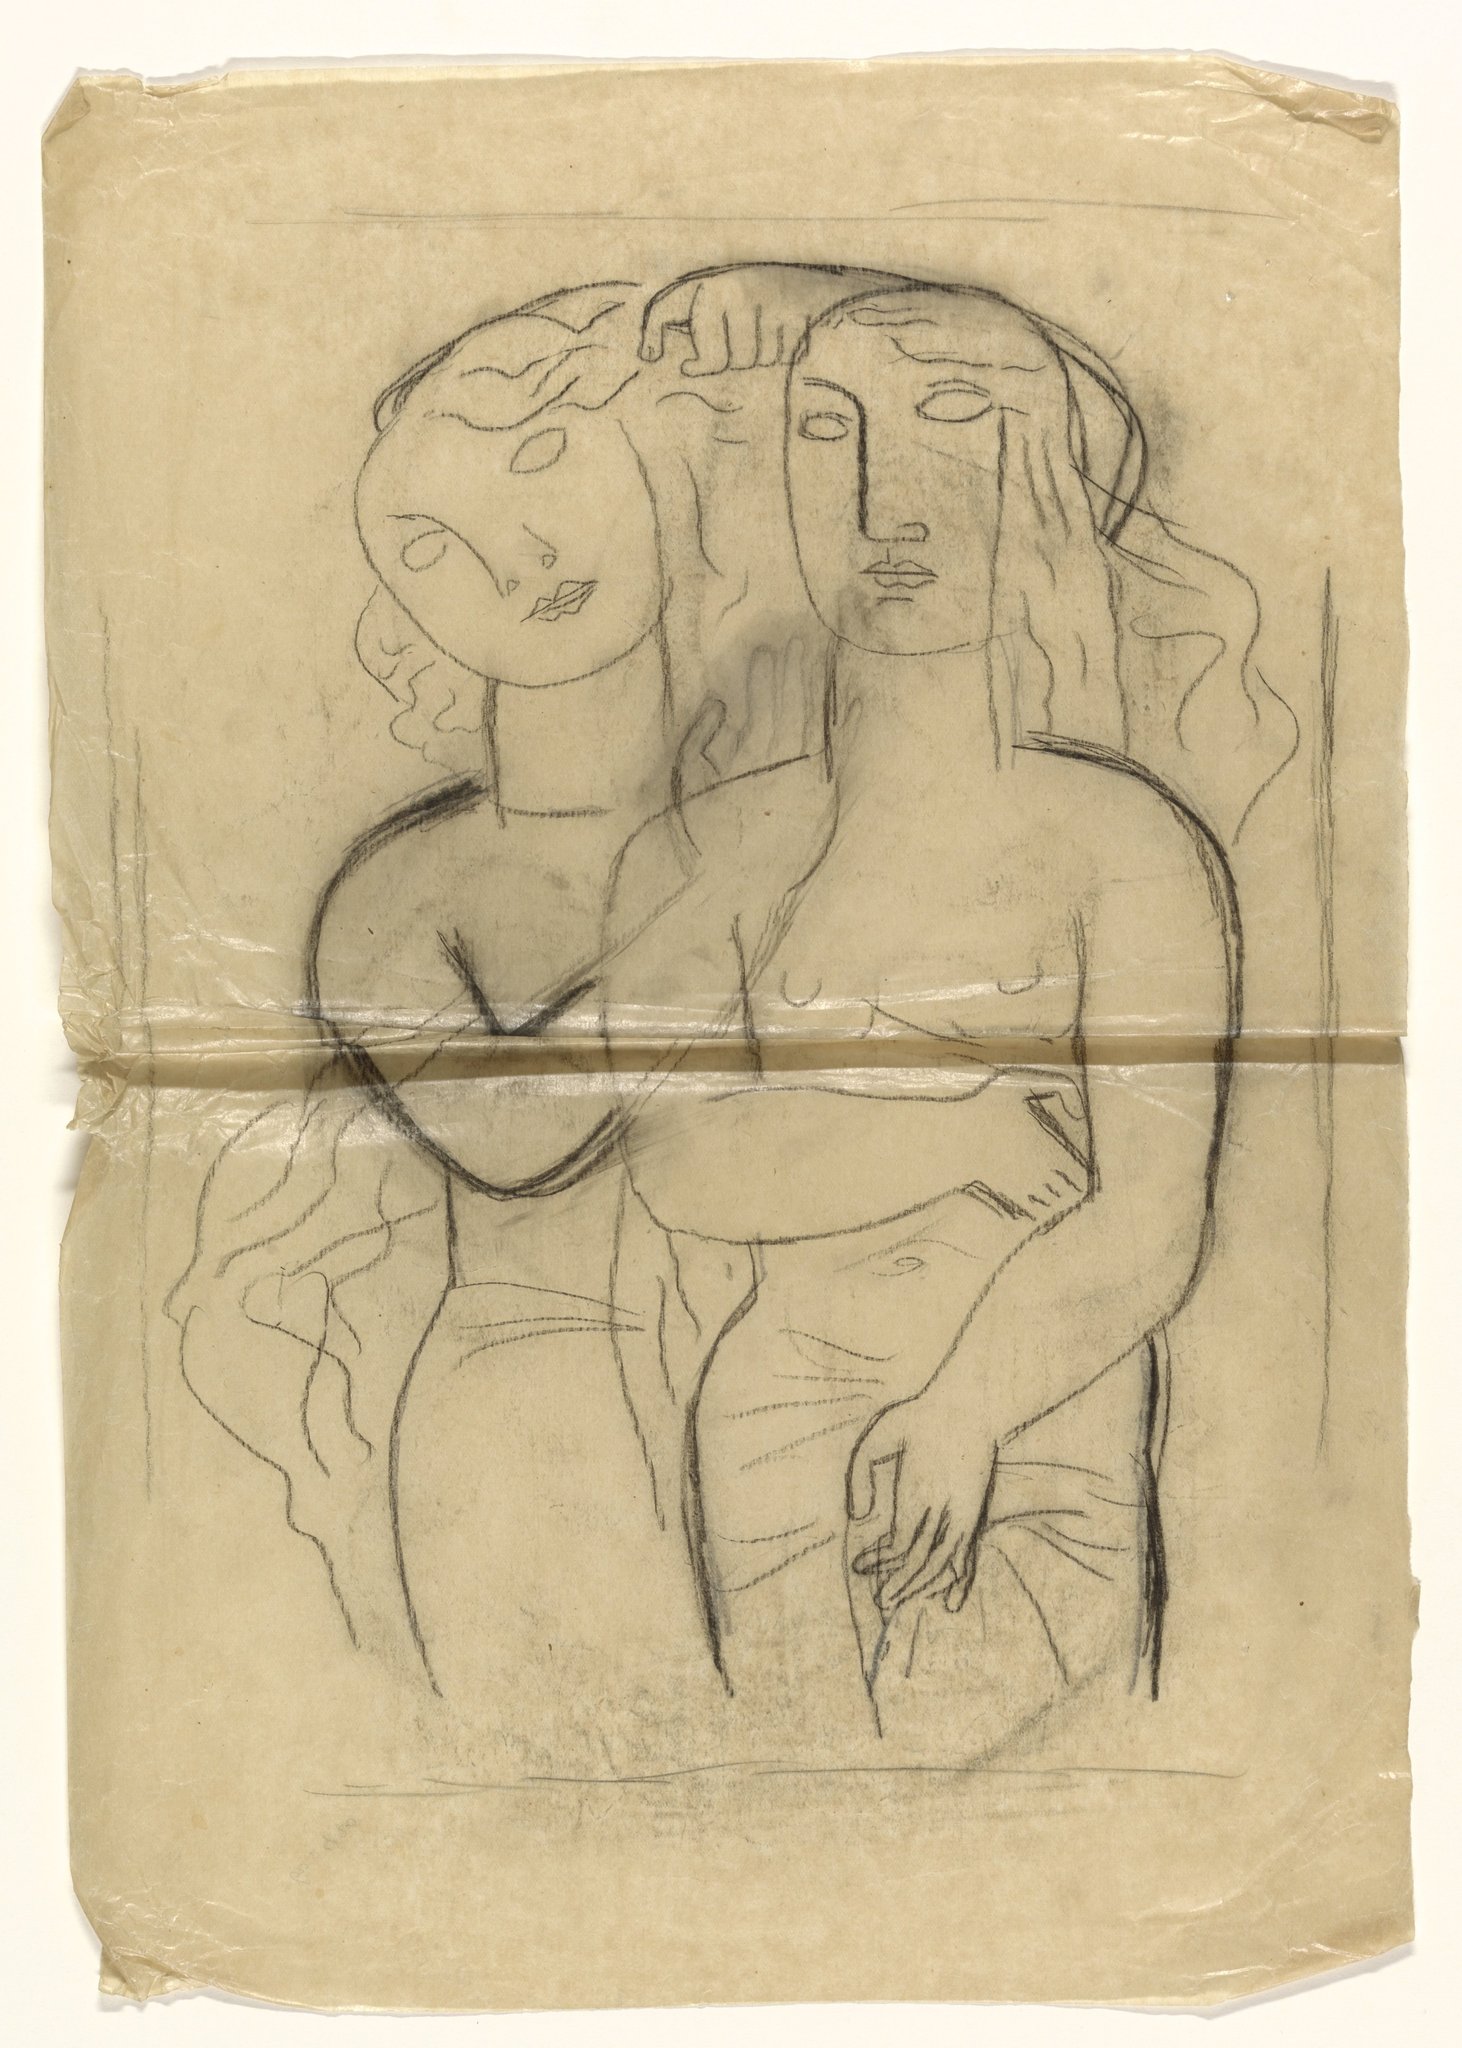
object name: drawing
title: Twee staande vrouwen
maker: leo gestel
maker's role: draughtsman, print maker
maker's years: 1881-1941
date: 1891-1941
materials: chalk, paper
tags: standing figure - aa - female human figure